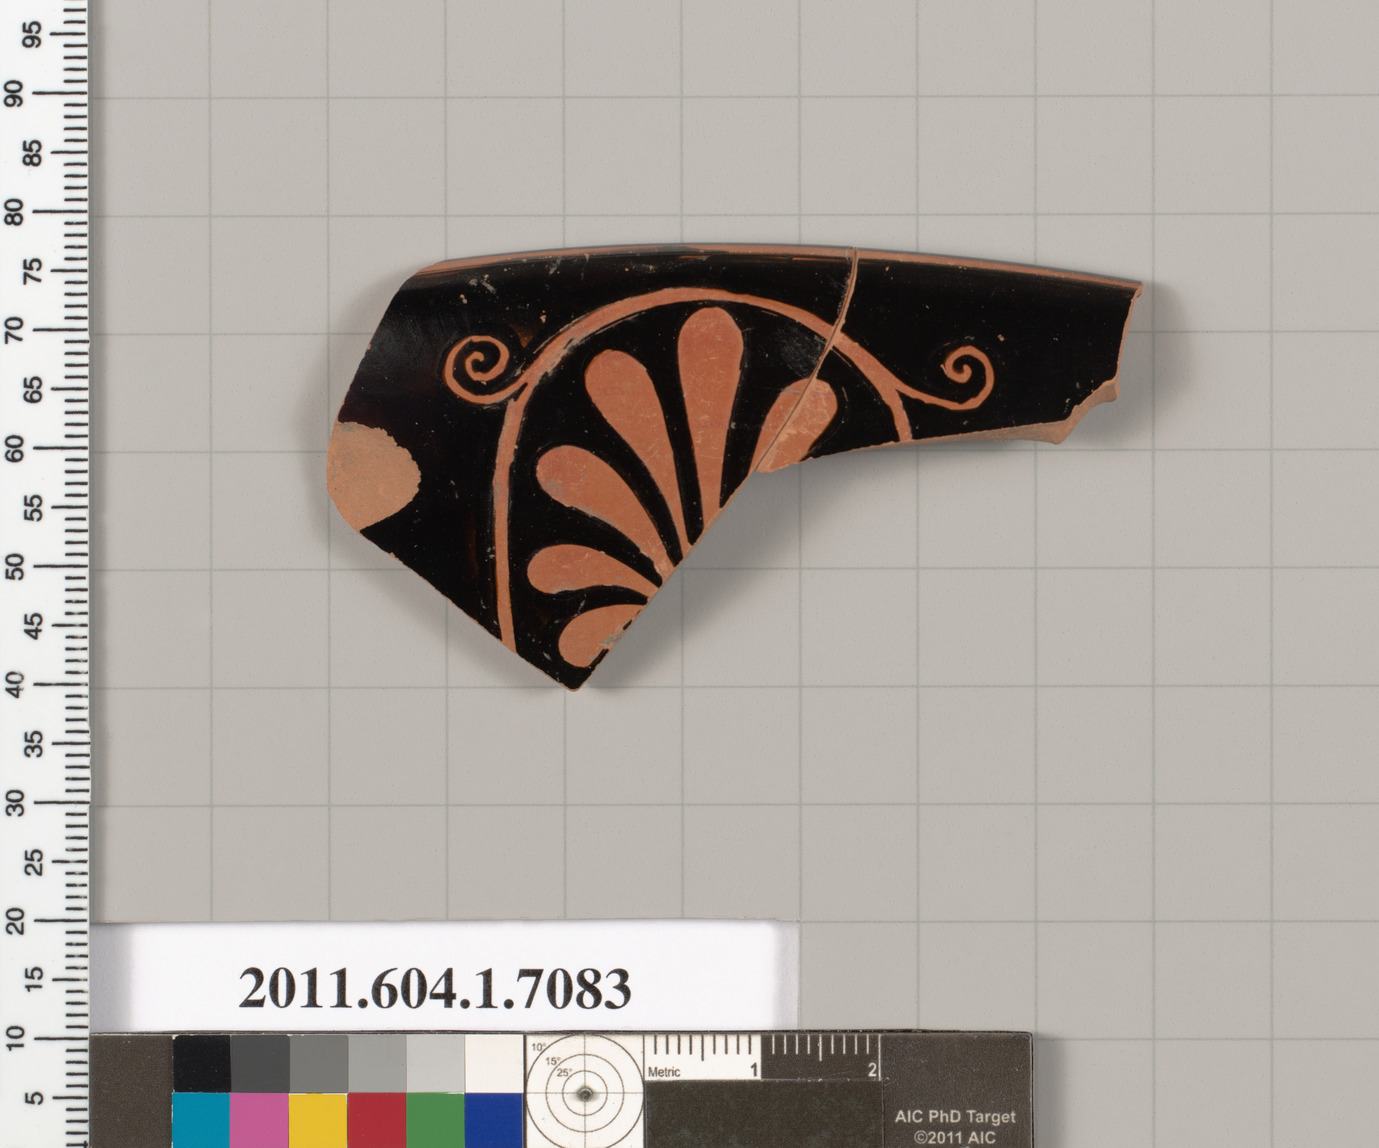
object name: kylix fragment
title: Terracotta rim fragment of a kylix (drinking cup)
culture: greek, attic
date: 500-480 BCE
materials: terracotta